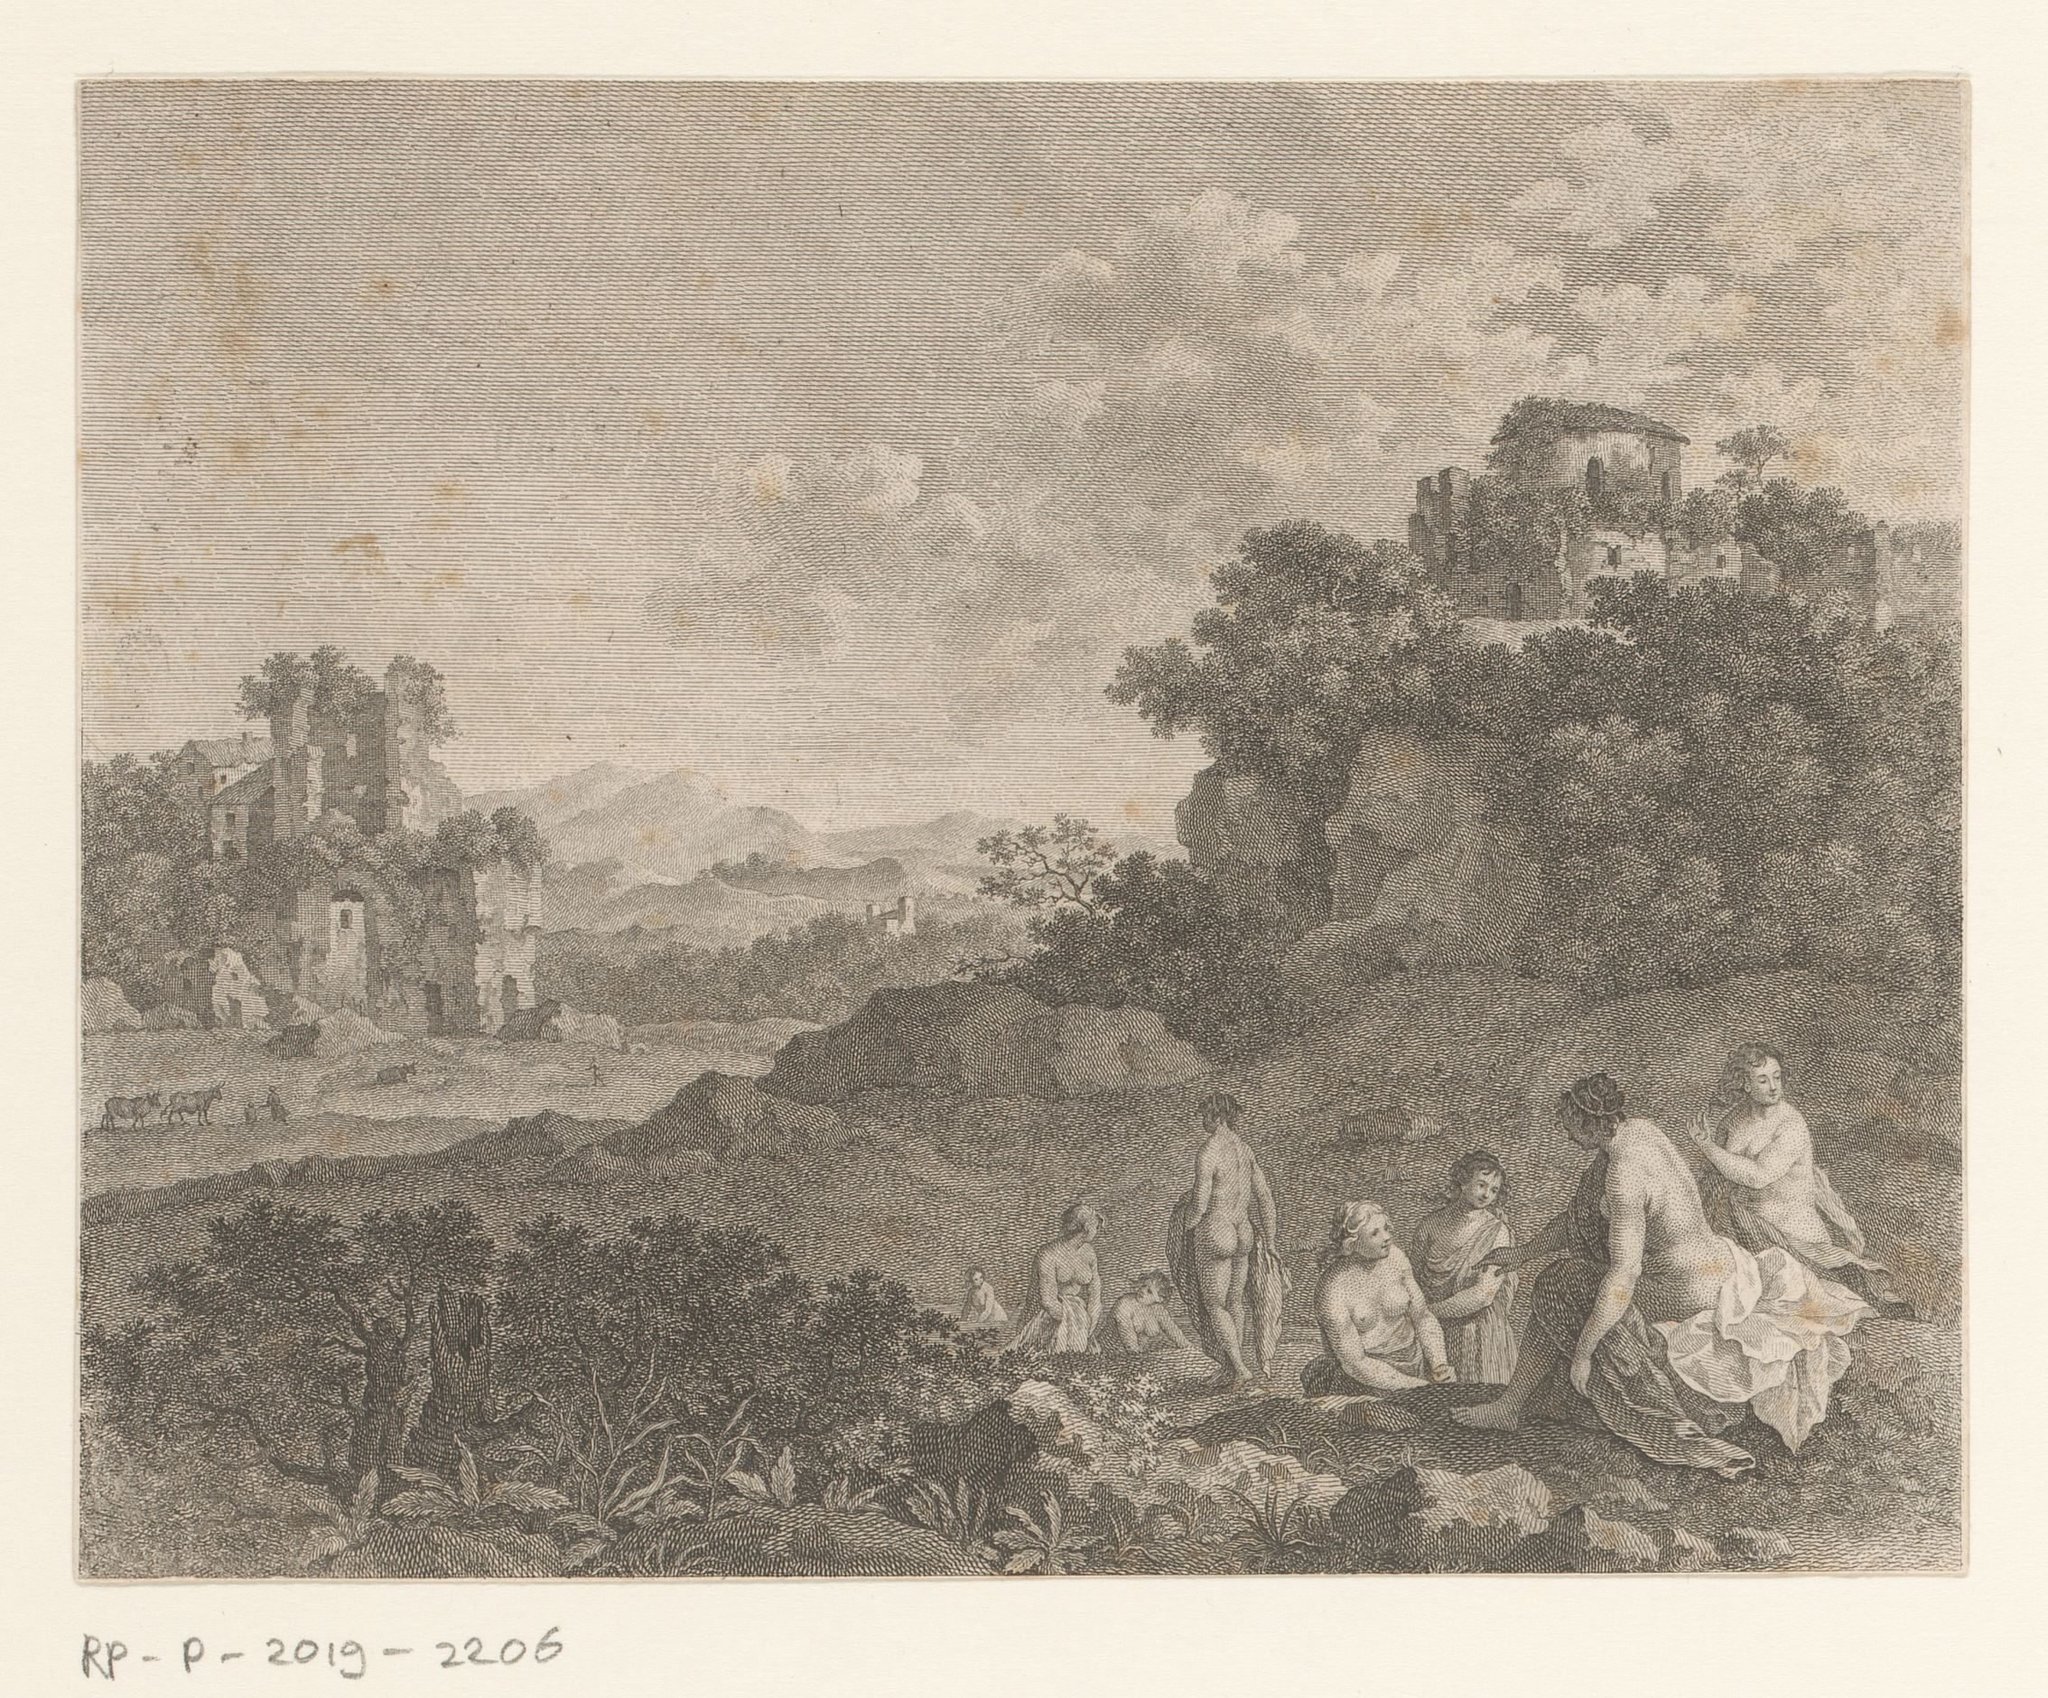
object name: print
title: Badende vrouwen of nimfen in een landschap met ruïnes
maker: Anonymous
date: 1650-1750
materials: paper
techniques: engraving, etching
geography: france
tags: nymphs (in general); 'ninfe in commune' (ripa), landscape with ruins, washing and bathing - aa - in the open air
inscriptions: inscription: ‘'Cabinet Porcellain' (?) of 'Cabinet Poullain' (?)’, collector's mark: Lugt 2228